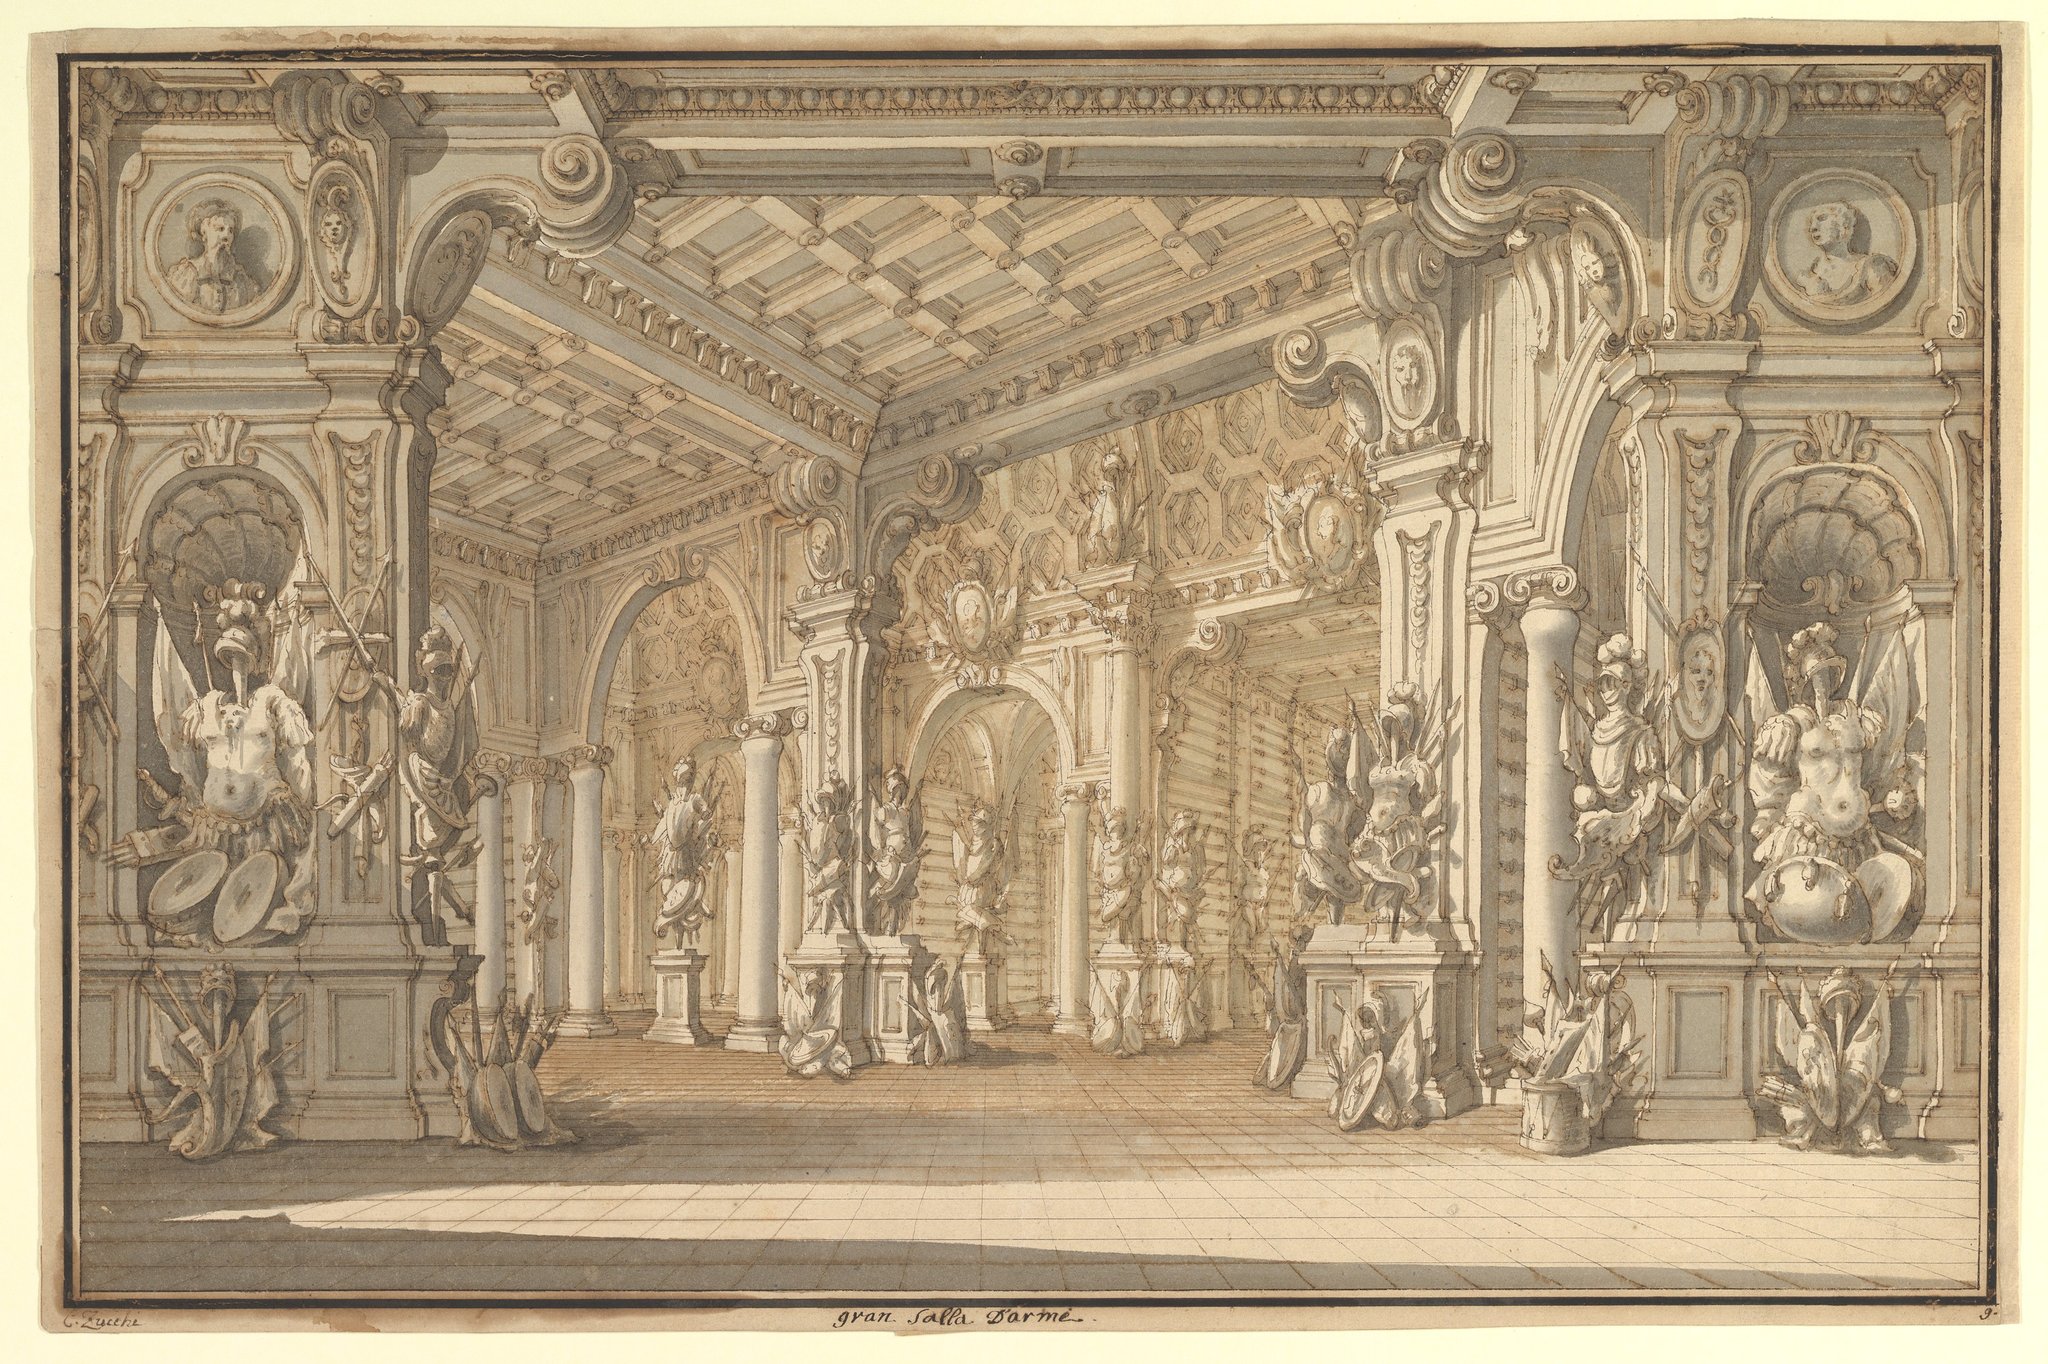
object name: drawing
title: Design for a Stage Set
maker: carlo zucchi the younger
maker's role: artist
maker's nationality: italian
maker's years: 1728-1796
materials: ink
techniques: brush, pen, wash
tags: interiors,armor,stage design